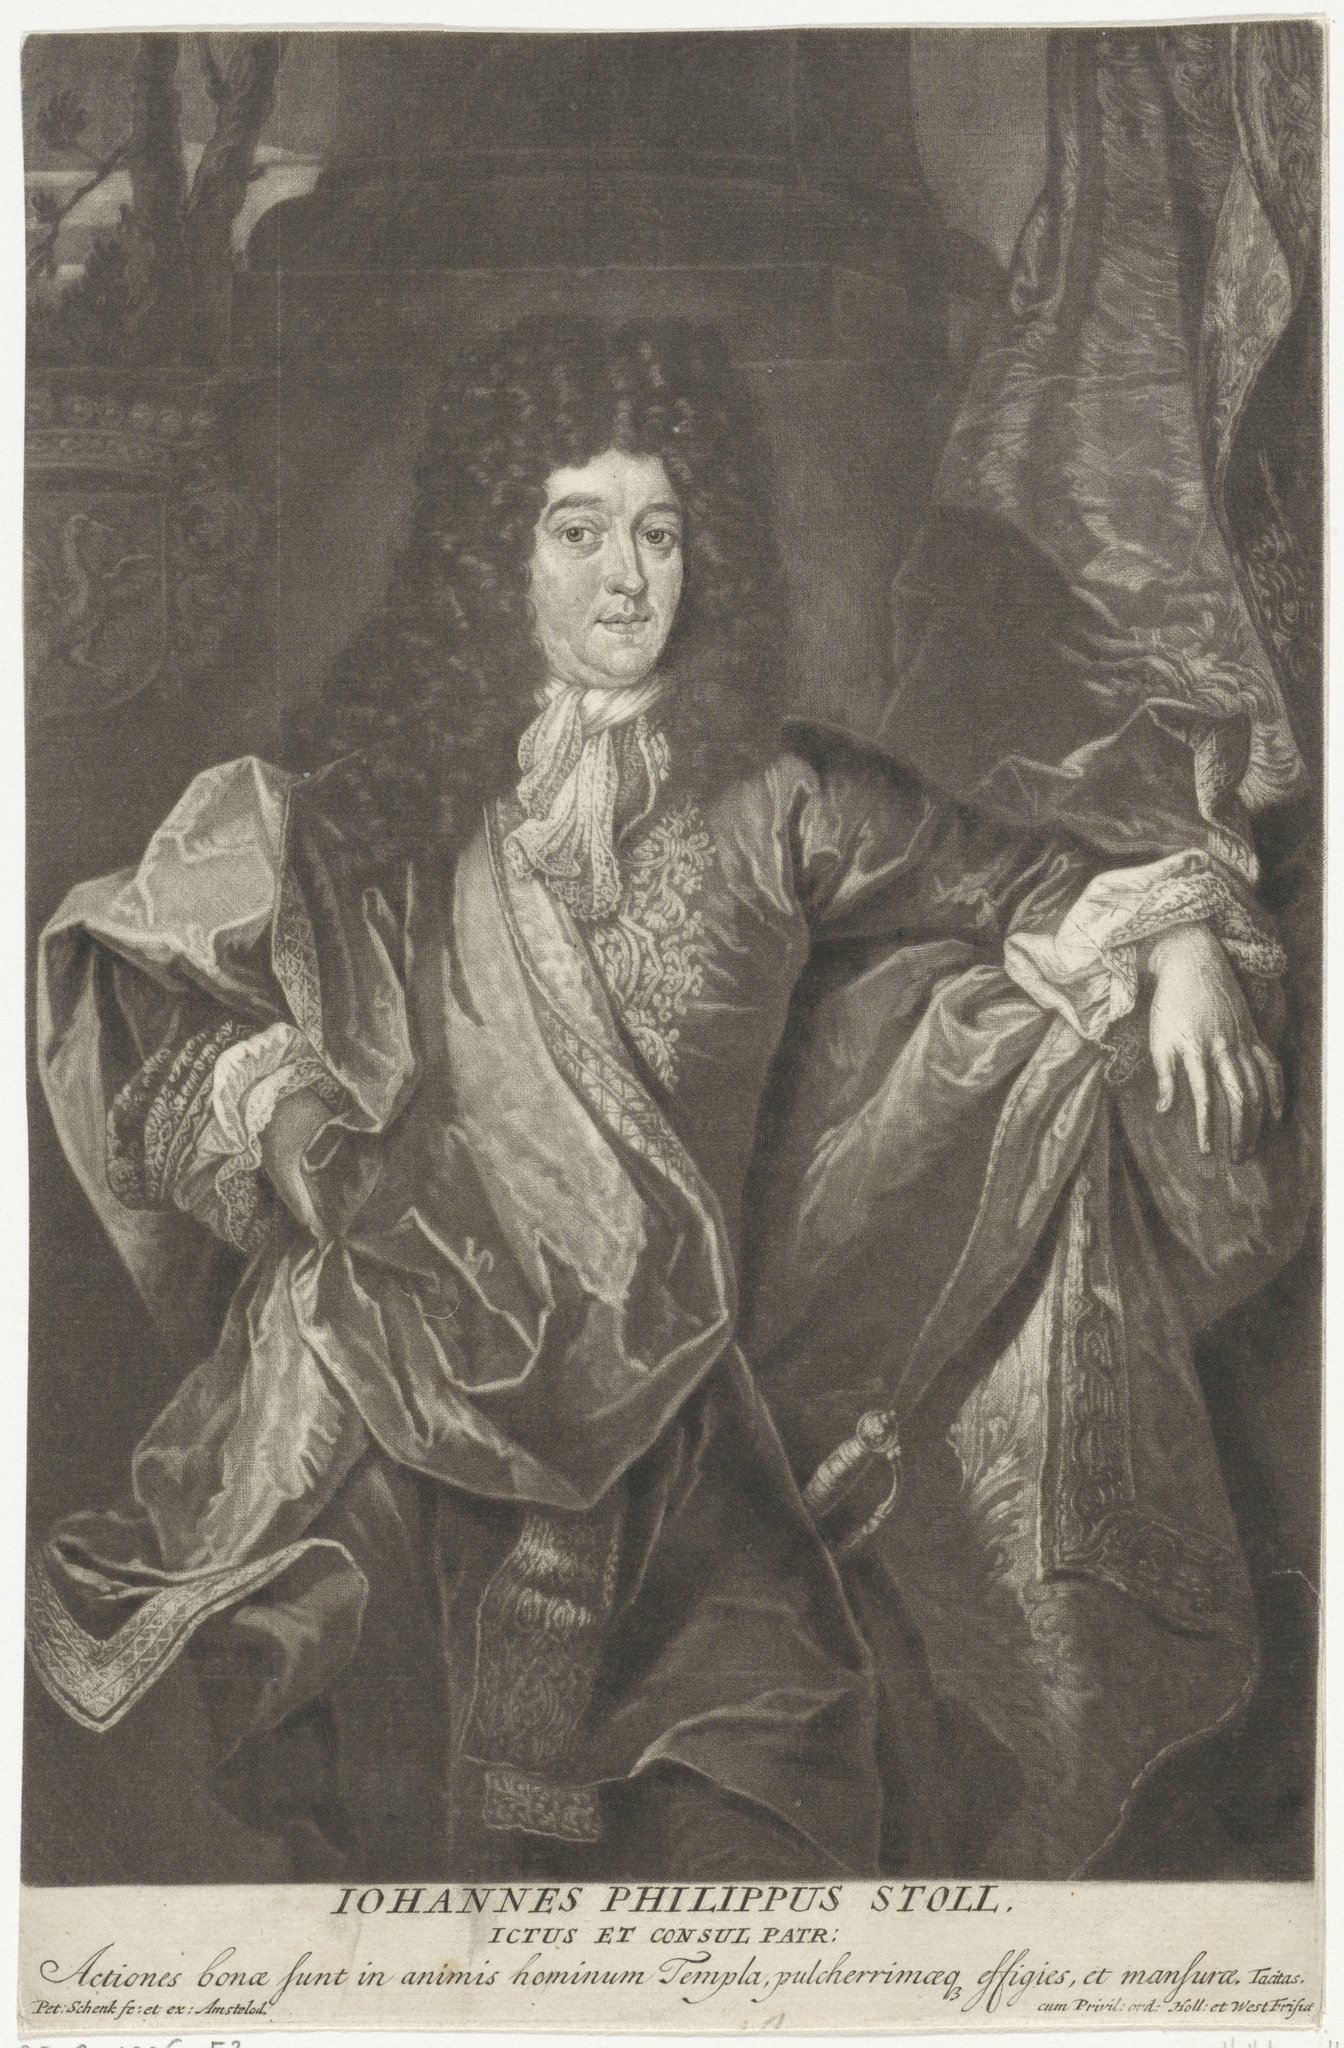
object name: print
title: Portret van Johann Philipp Stoll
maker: pieter schenk (i)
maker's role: print maker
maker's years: 1660-1711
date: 1670-1713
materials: paper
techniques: engraving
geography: amsterdam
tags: wig, armorial bearing, heraldry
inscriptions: collector's mark: Lugt 2228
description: Johann Philipp Stoll staat voor een zuil. Hij draagt een pruik. Op de achtergrond zijn familiewapen.